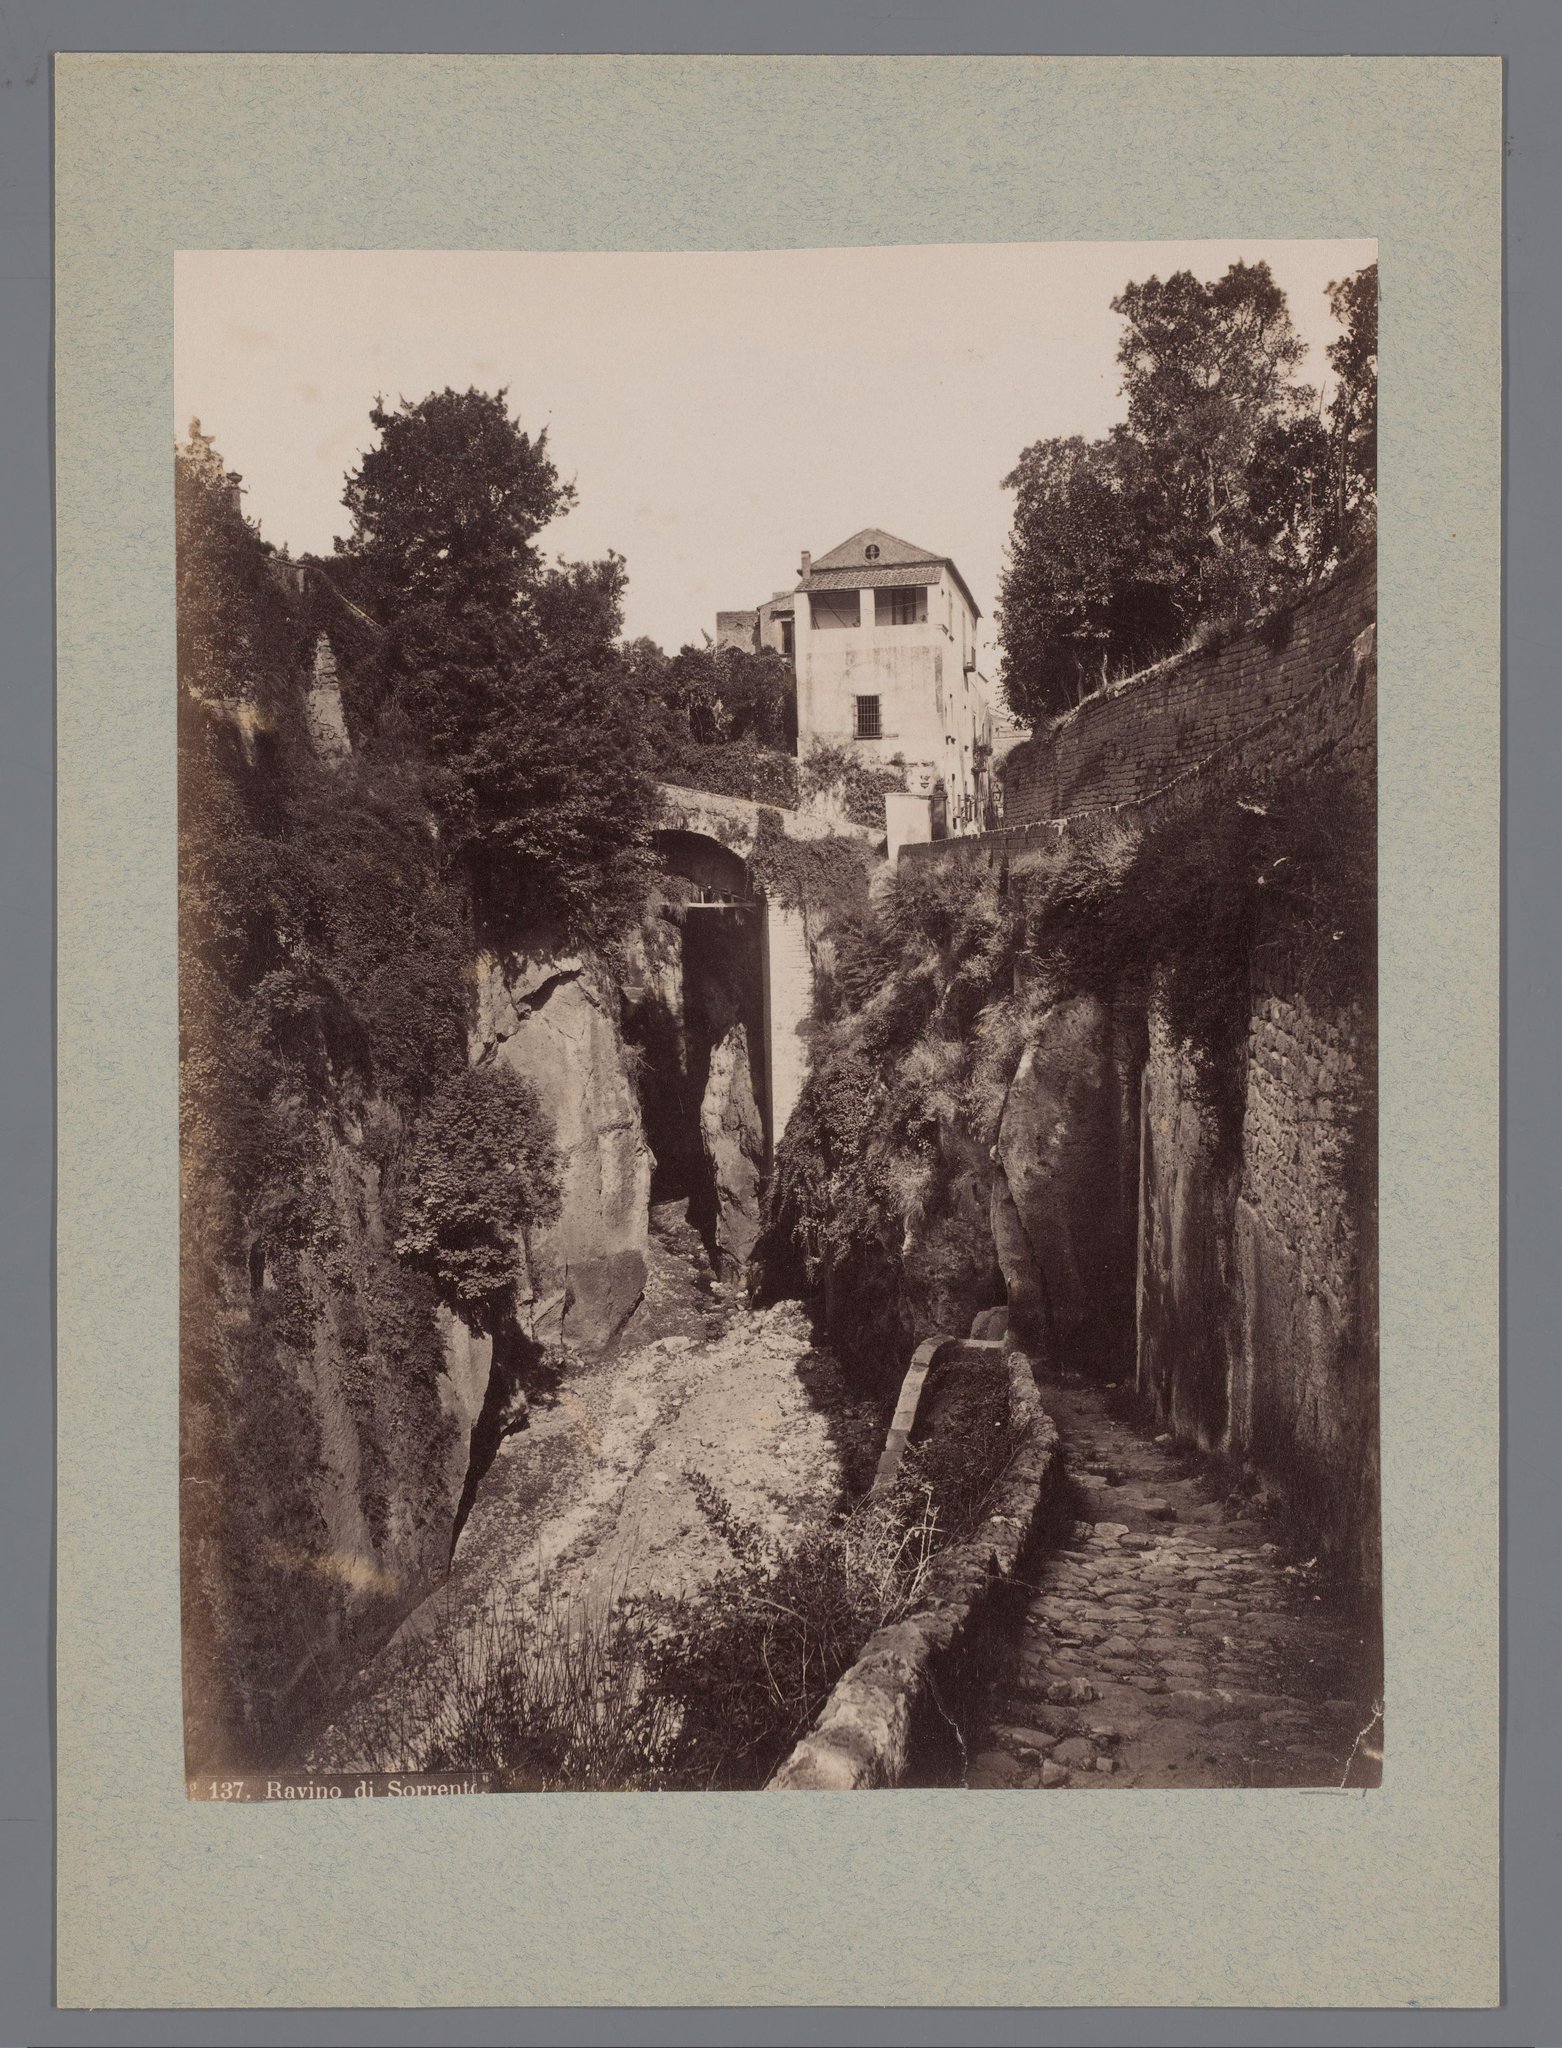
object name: photograph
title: Ravino di Sorrento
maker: giorgio sommer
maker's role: fotograaf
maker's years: 1834-1914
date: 1857-1914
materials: cardboard, paper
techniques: albumen print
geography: sorrento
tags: landscape with bridge, viaduct or aqueduct, ravine, chasm, abyss, canyon, sorrento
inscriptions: inscription: ‘(+) Sommer/ MB/ nagekomen Diepr.’, number: ‘137.’